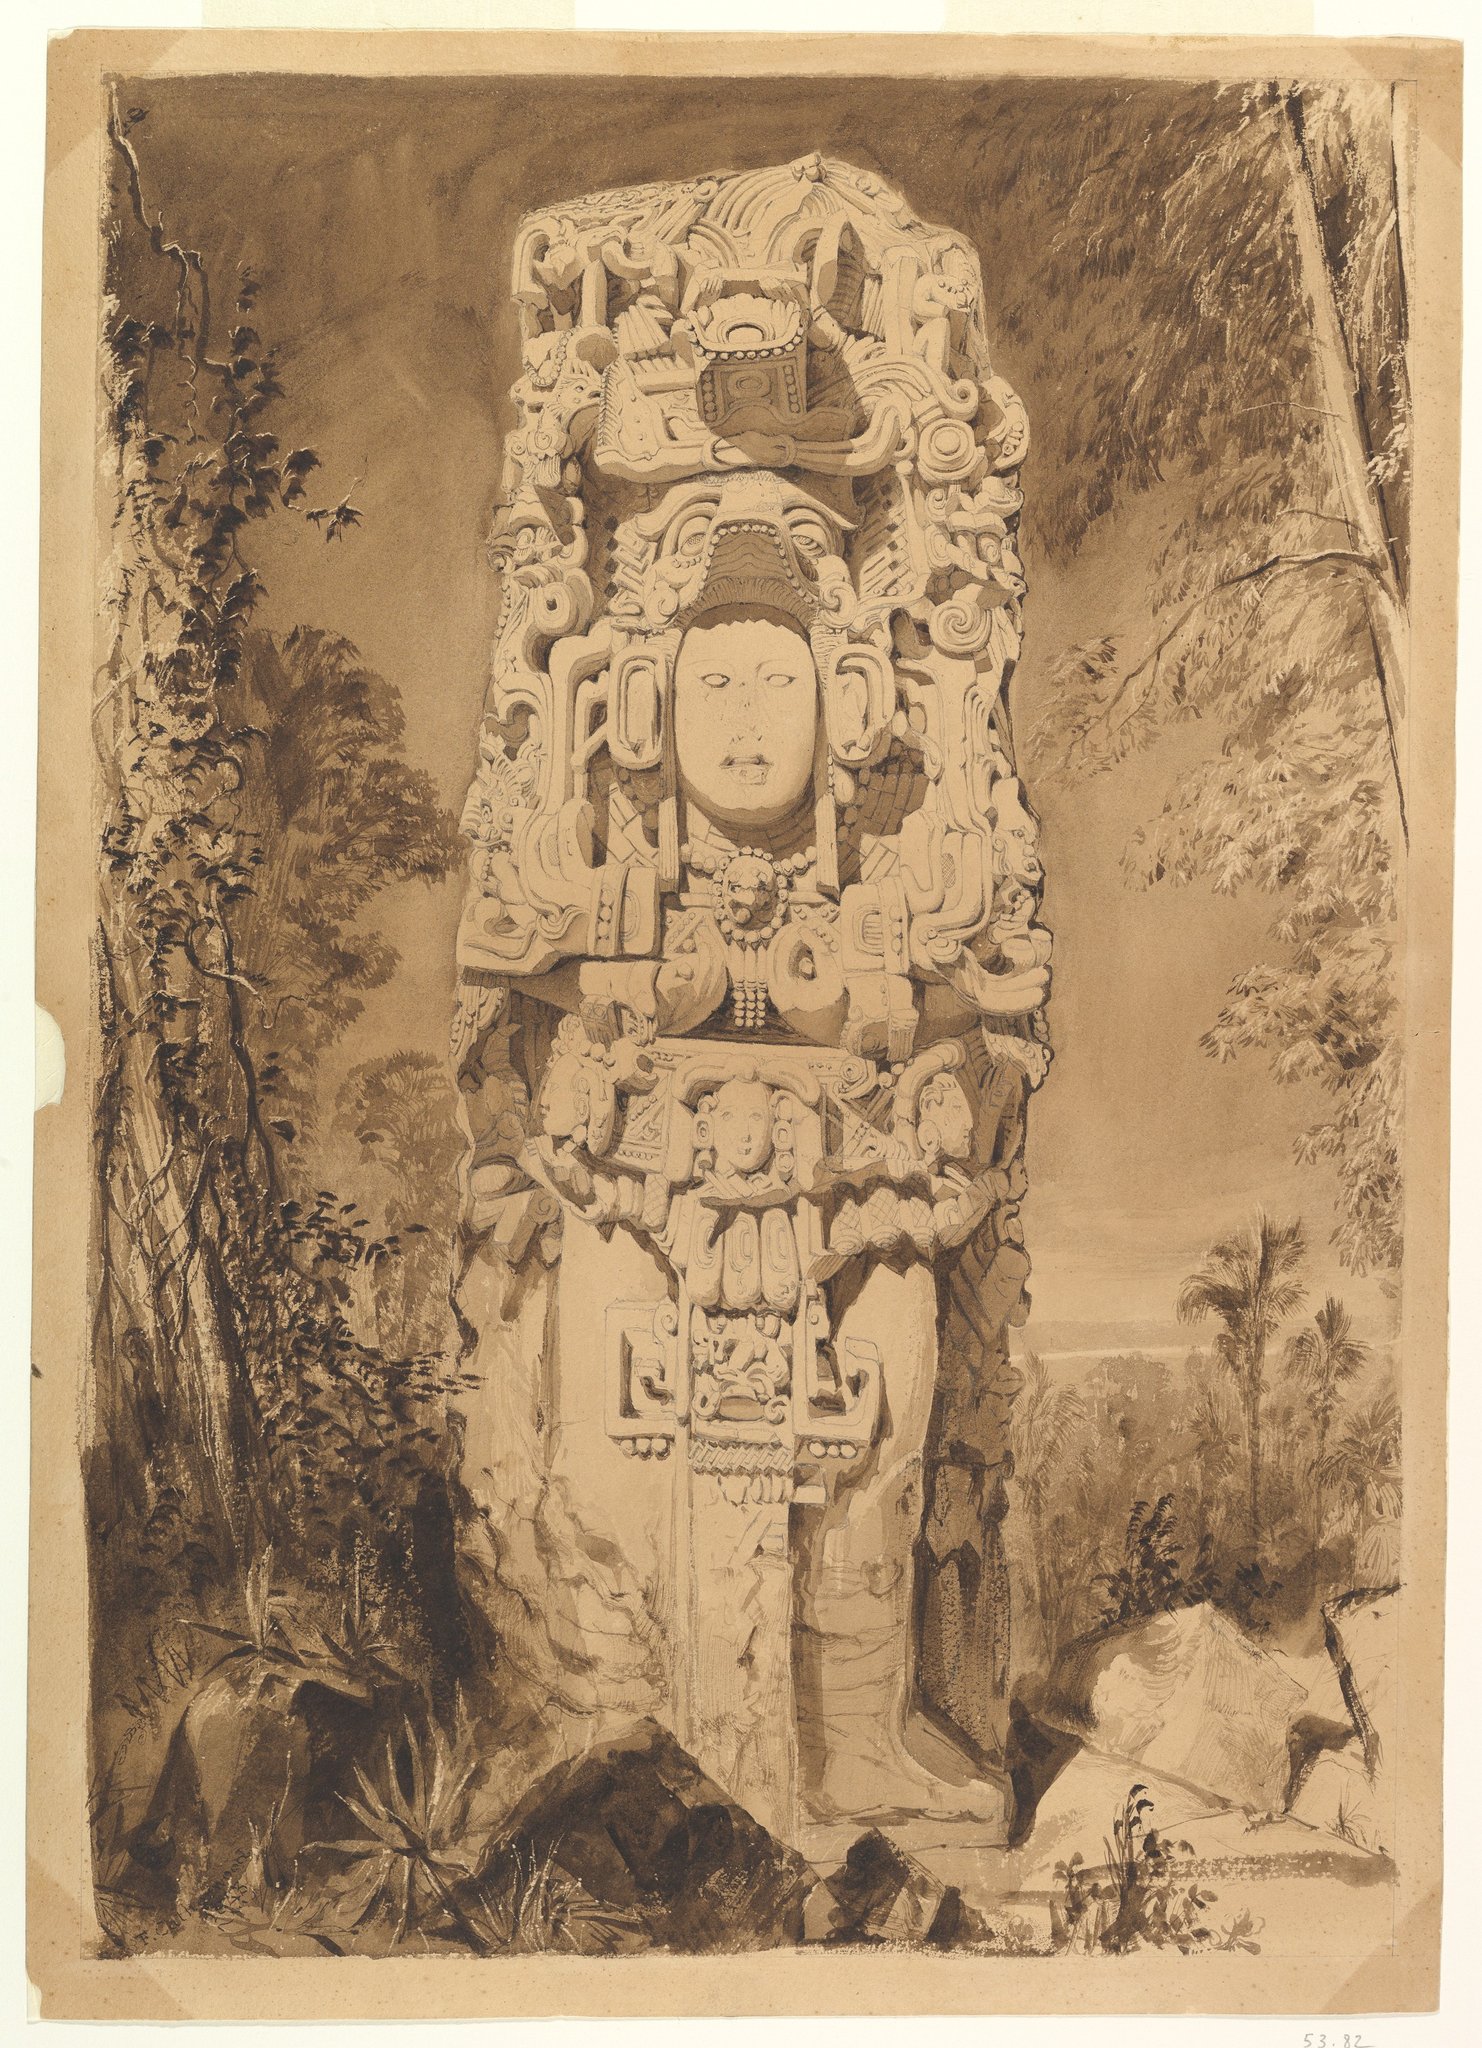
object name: drawing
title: Stela at Copán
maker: frederick catherwood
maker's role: artist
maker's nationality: british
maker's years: 1799-1854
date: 1843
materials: graphite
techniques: brush, wash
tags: sculpture,monuments,faces